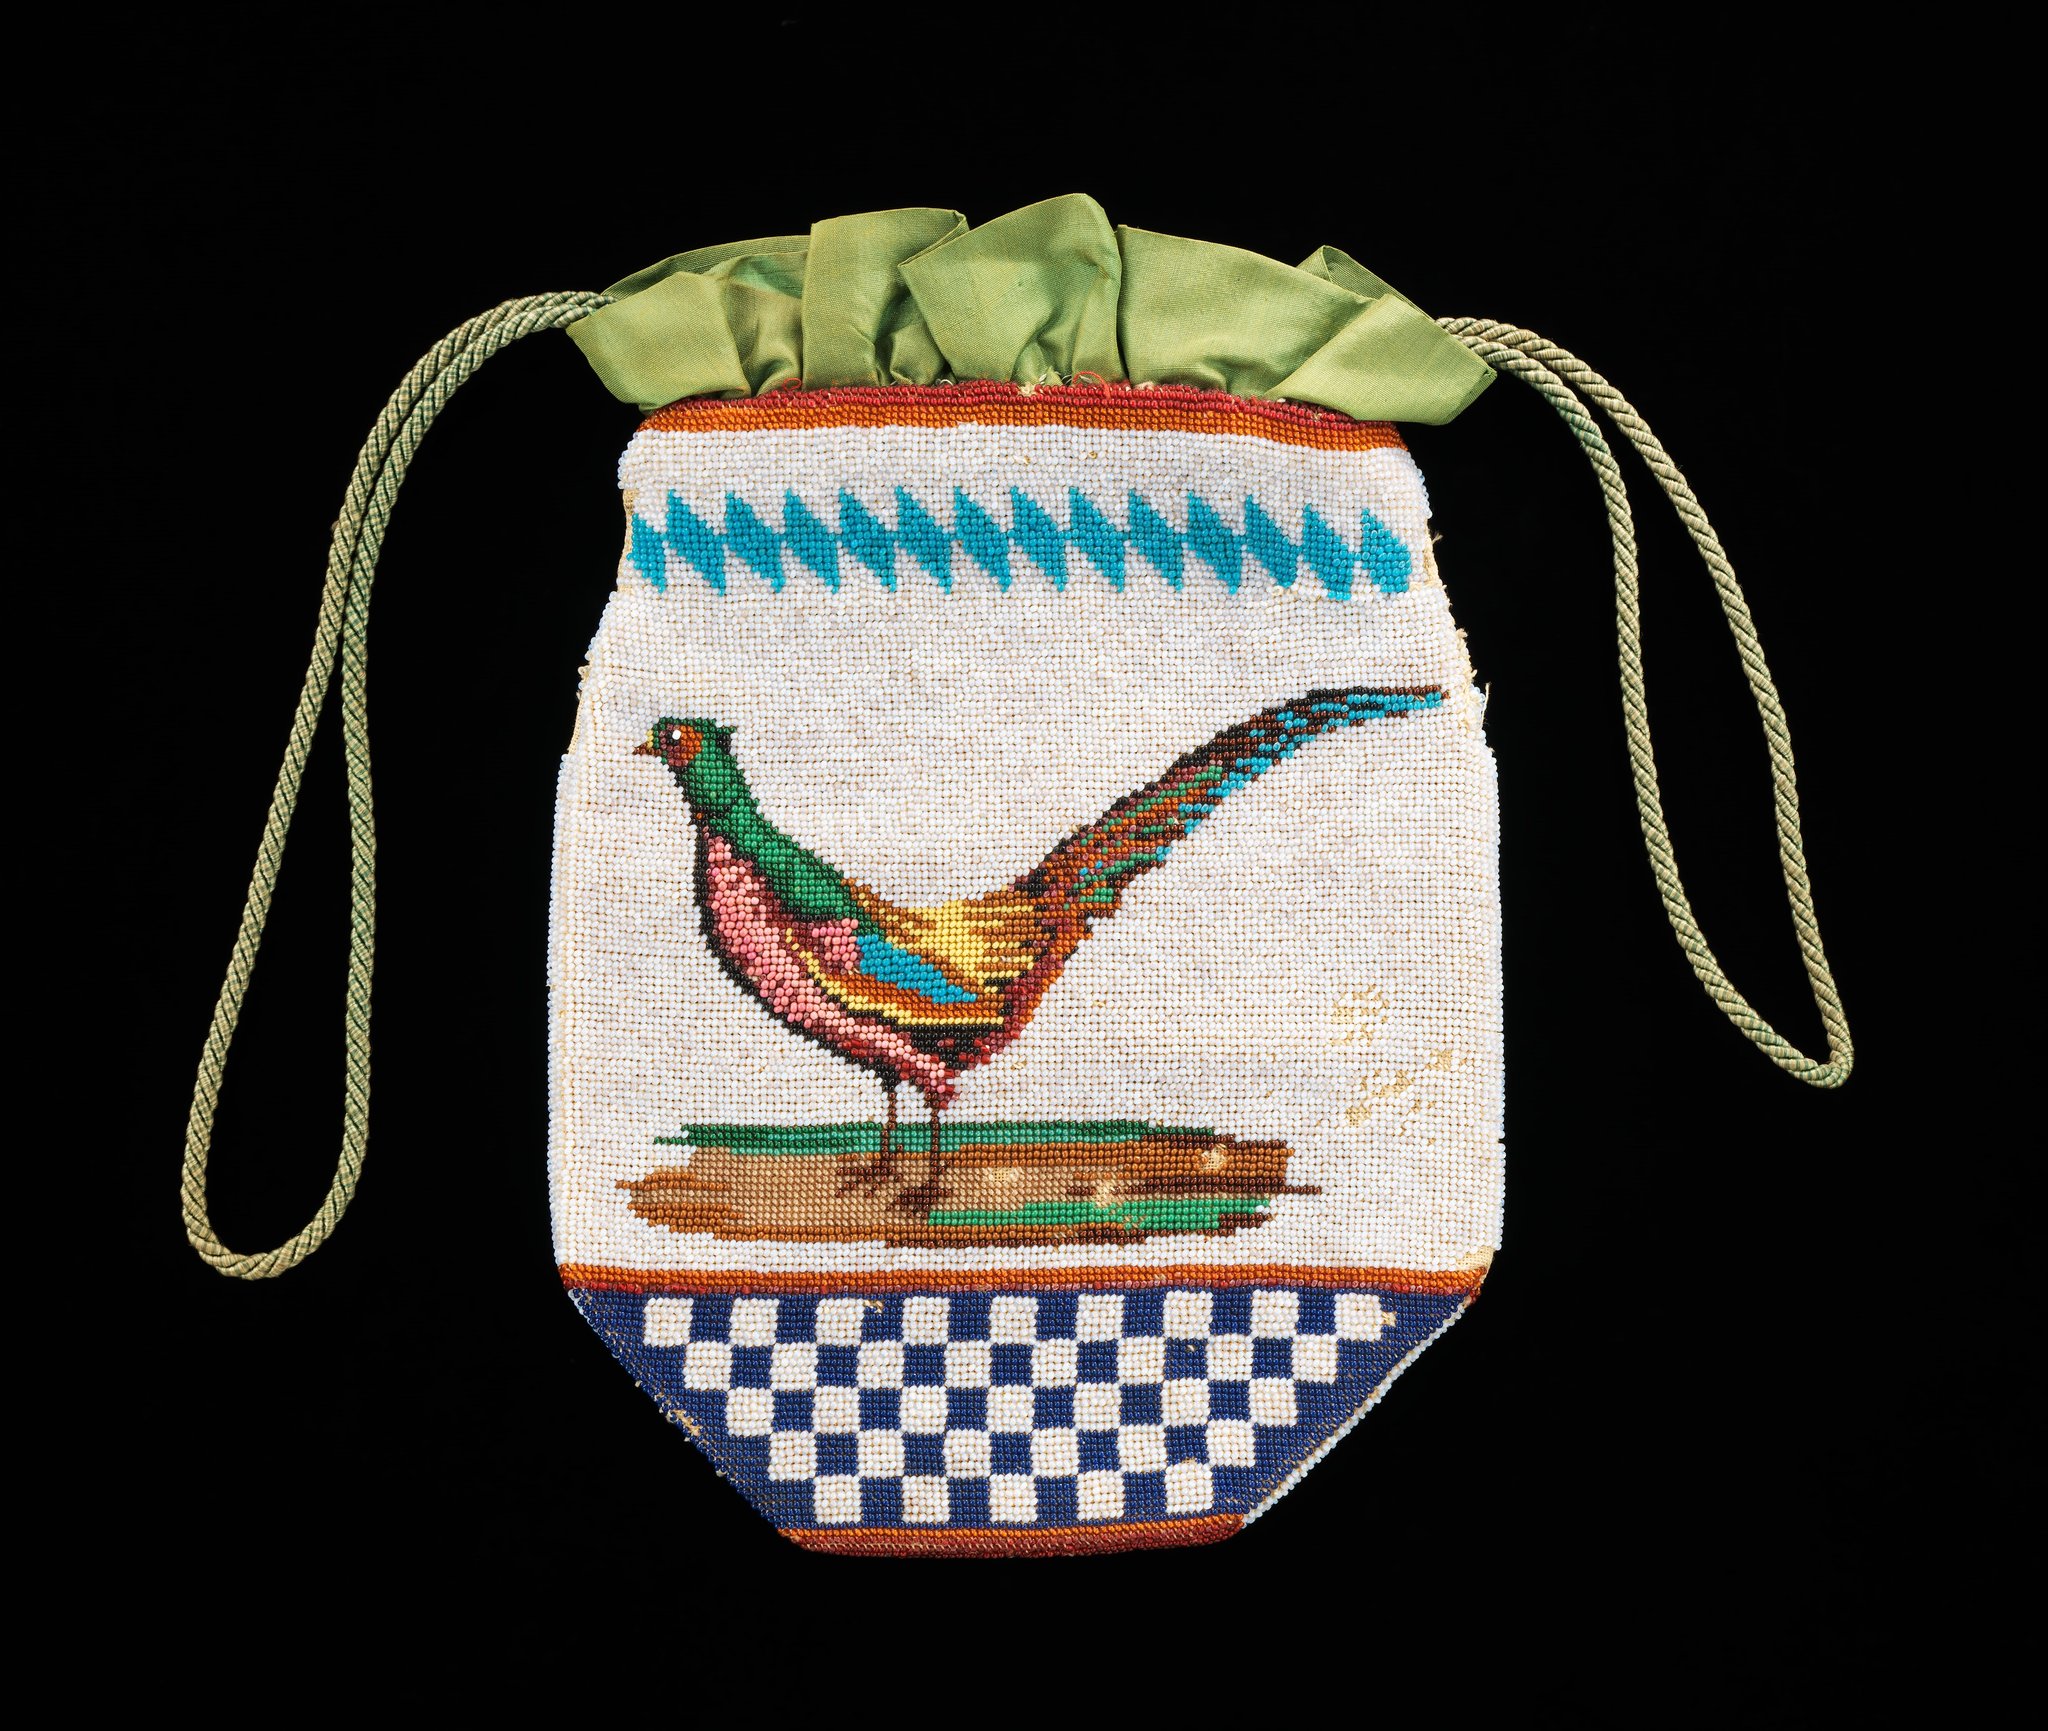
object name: pouch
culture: italian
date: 1820-1850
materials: glass, linen, silk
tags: birds